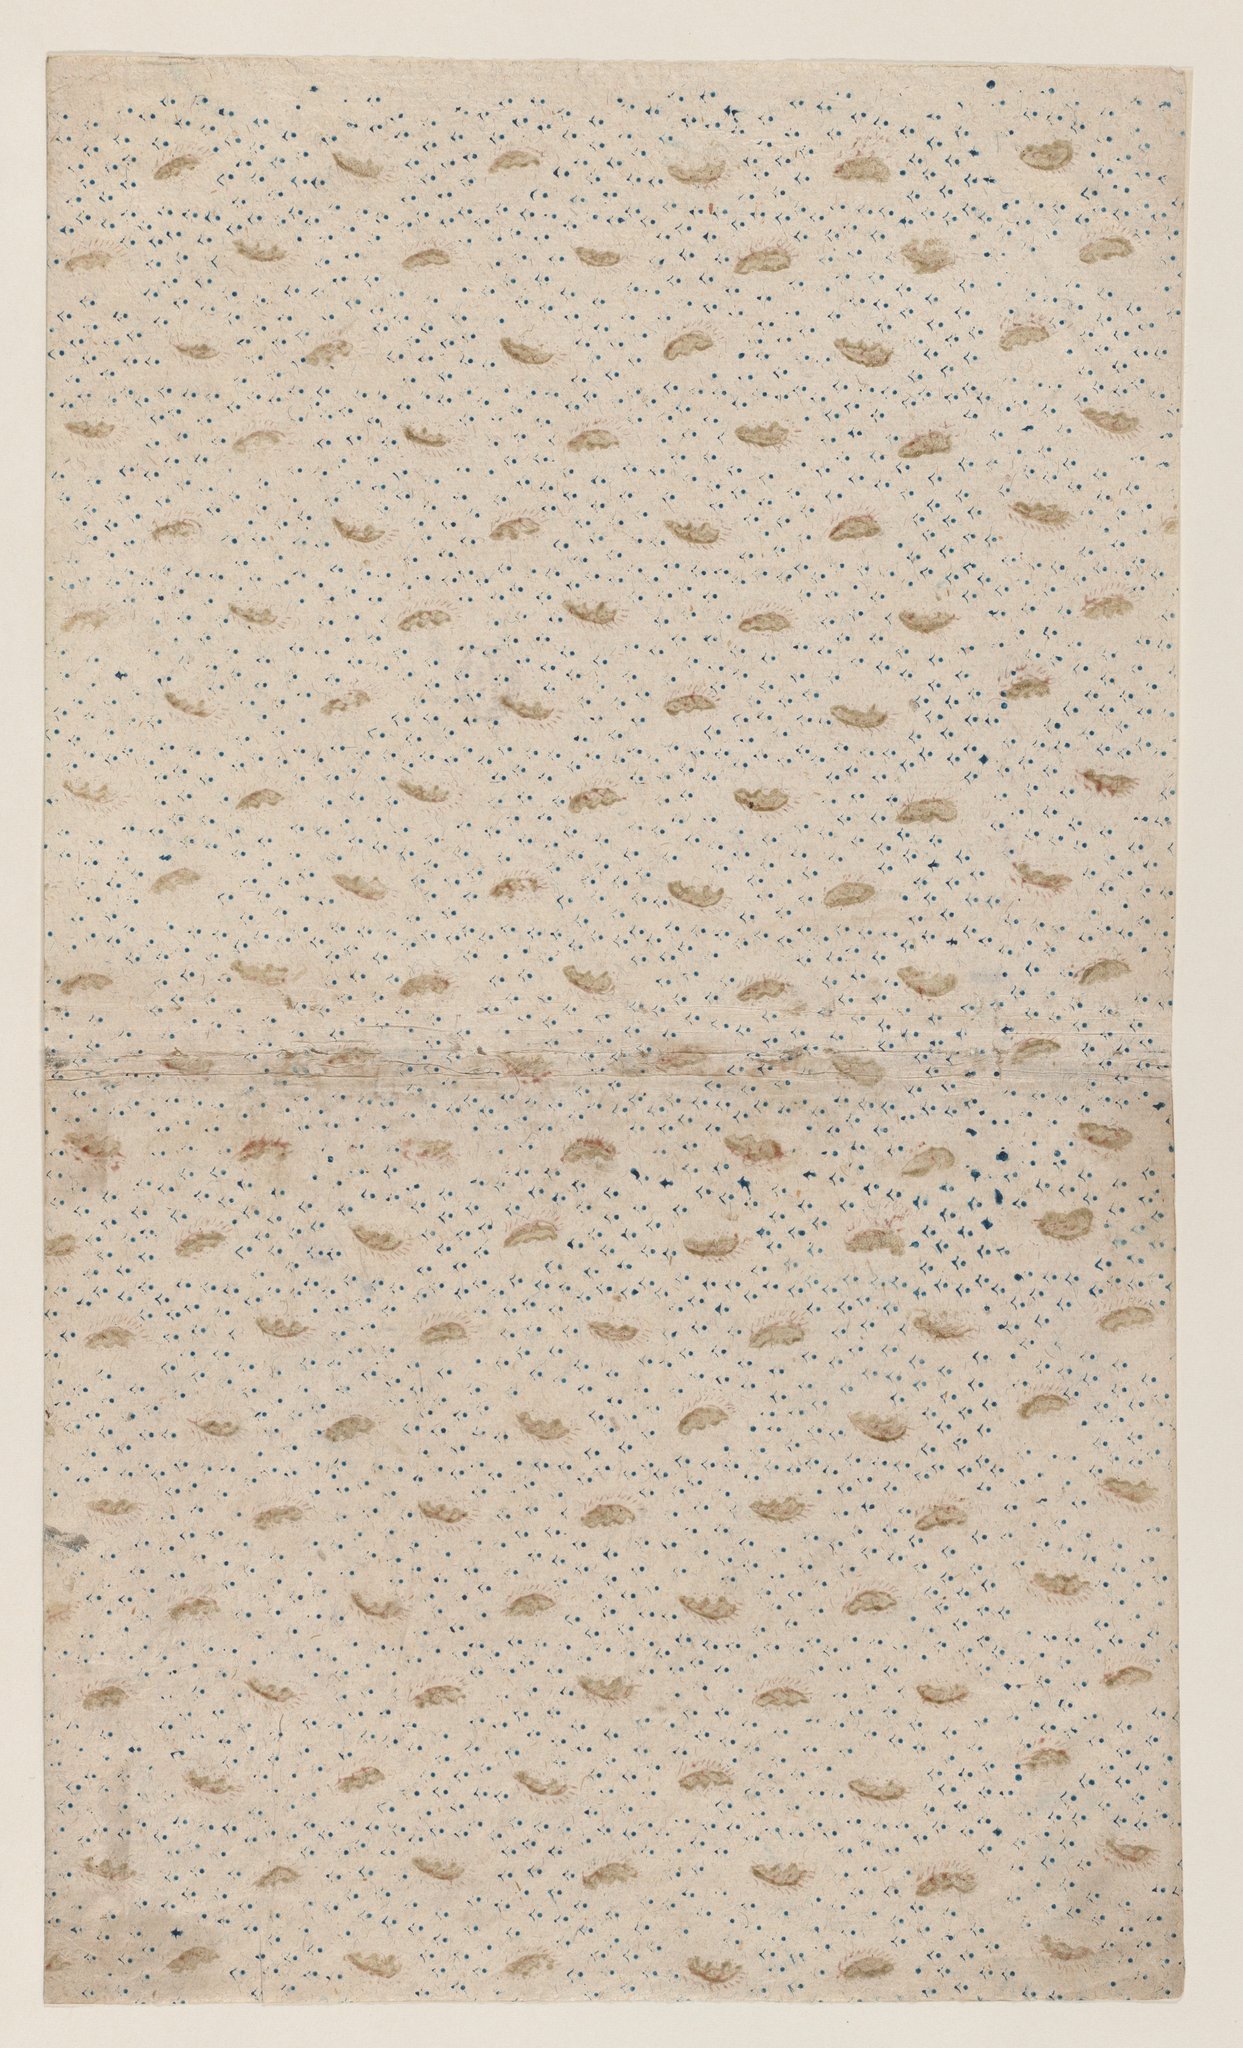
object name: print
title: Book cover with overall abstract design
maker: Anonymous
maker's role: artist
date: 1801-1900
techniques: relief print